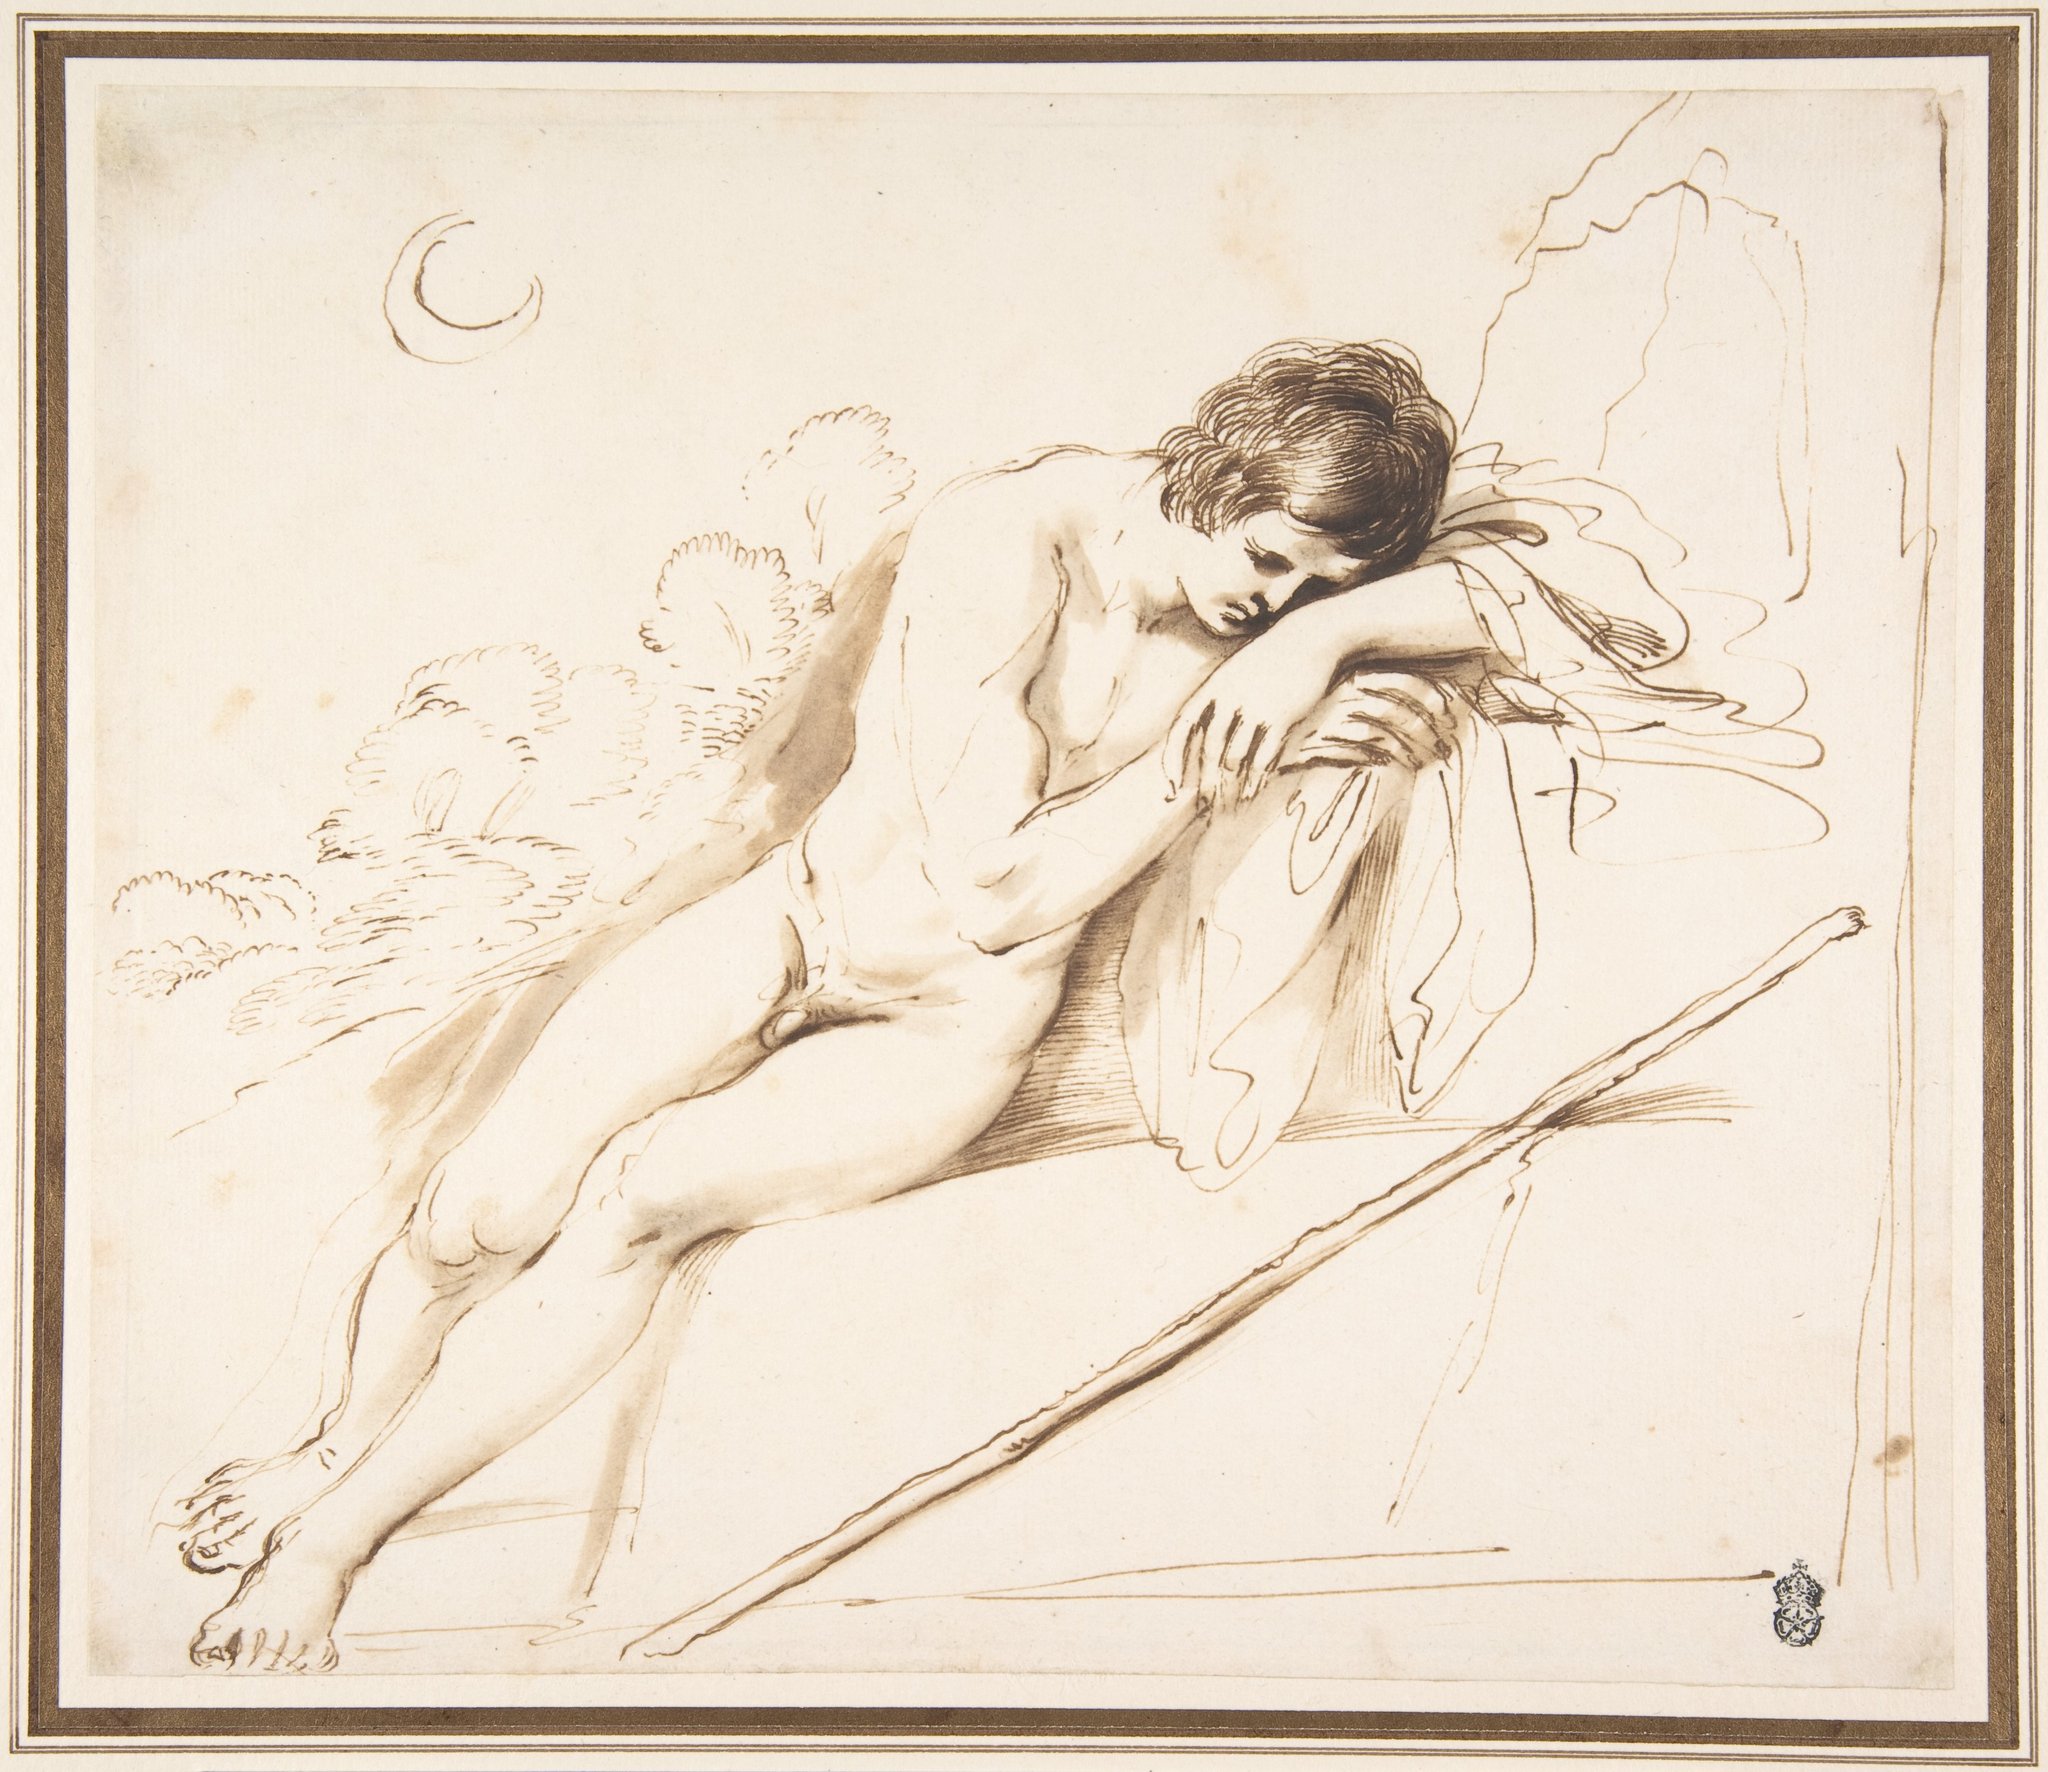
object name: drawing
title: Endymion Sleeping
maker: guercino (giovanni francesco barbieri)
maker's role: artist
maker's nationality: italian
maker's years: 1591-1666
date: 1635-1650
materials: ink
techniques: brush, pen, wash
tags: sleeping,male nudes